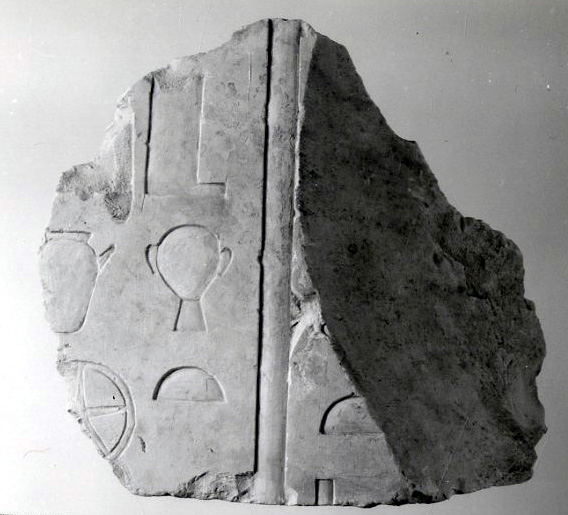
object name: relief fragment, tomb of meketre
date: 1981-1975 BCE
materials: limestone, paint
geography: egypt